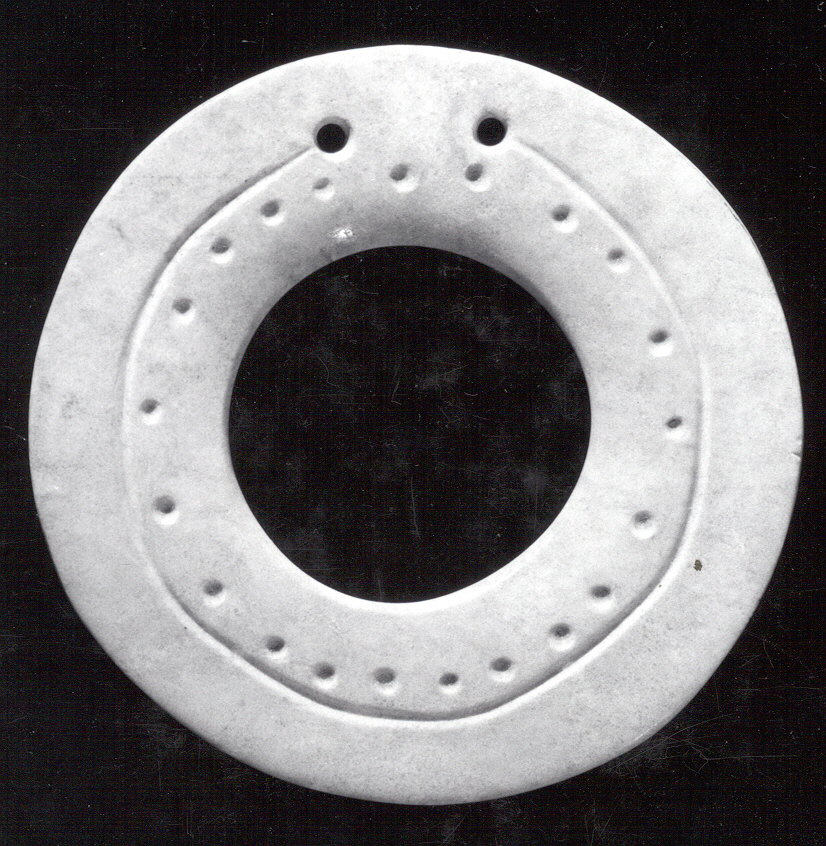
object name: pendant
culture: atlantic watershed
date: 301-800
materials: jade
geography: costa rica